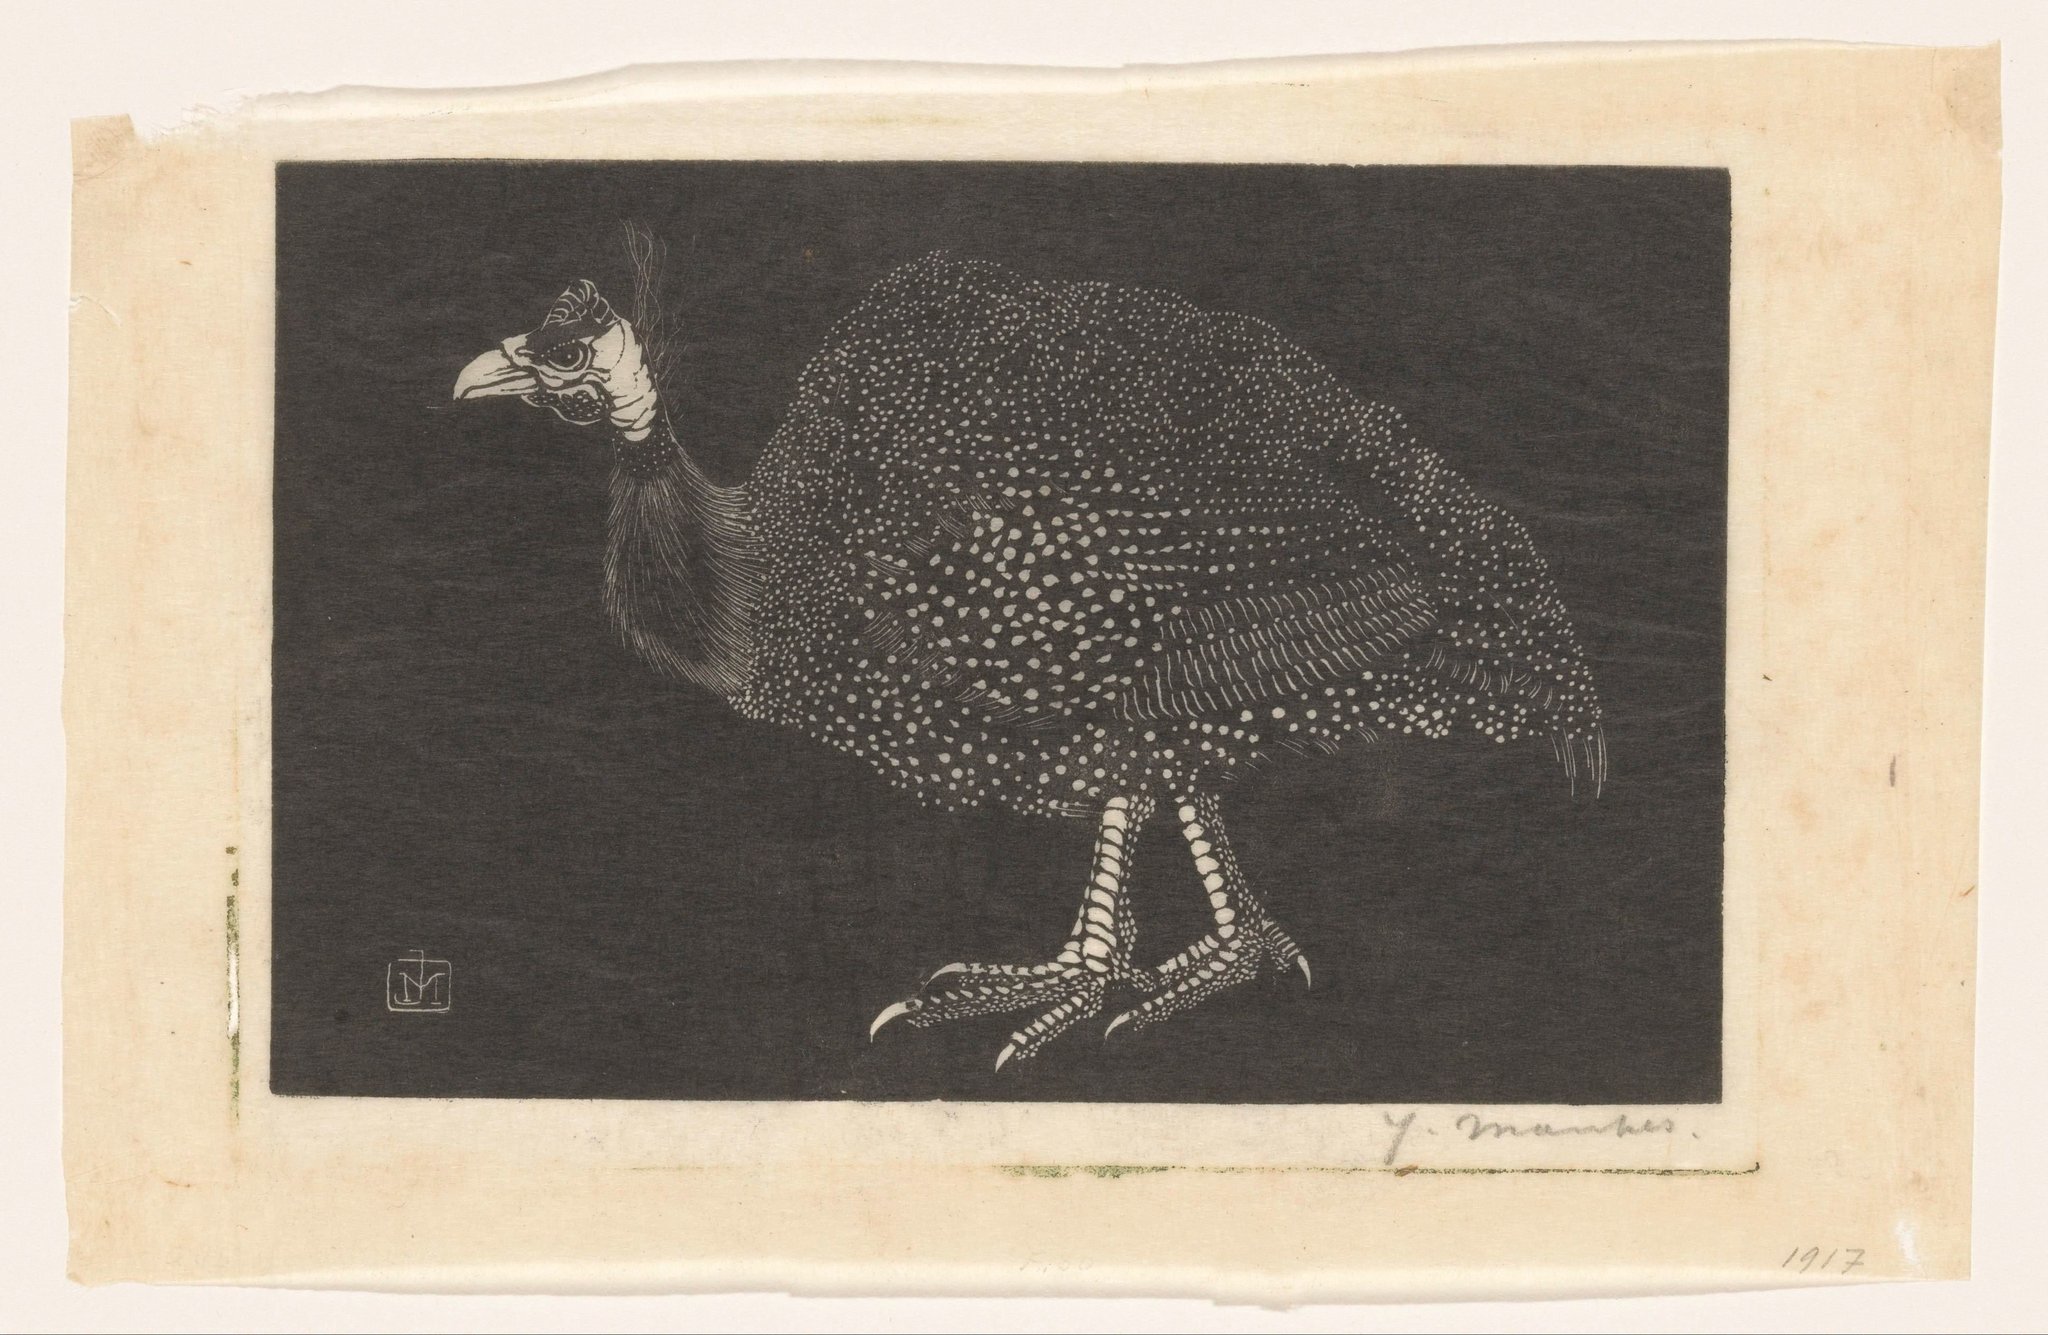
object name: print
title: Parelhoen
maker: jan mankes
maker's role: draughtsman, painter, print maker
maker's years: 1889-1920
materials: paper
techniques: engraving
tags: walker and runner birds: guineafowl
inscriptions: collector's mark: Lugt 2228